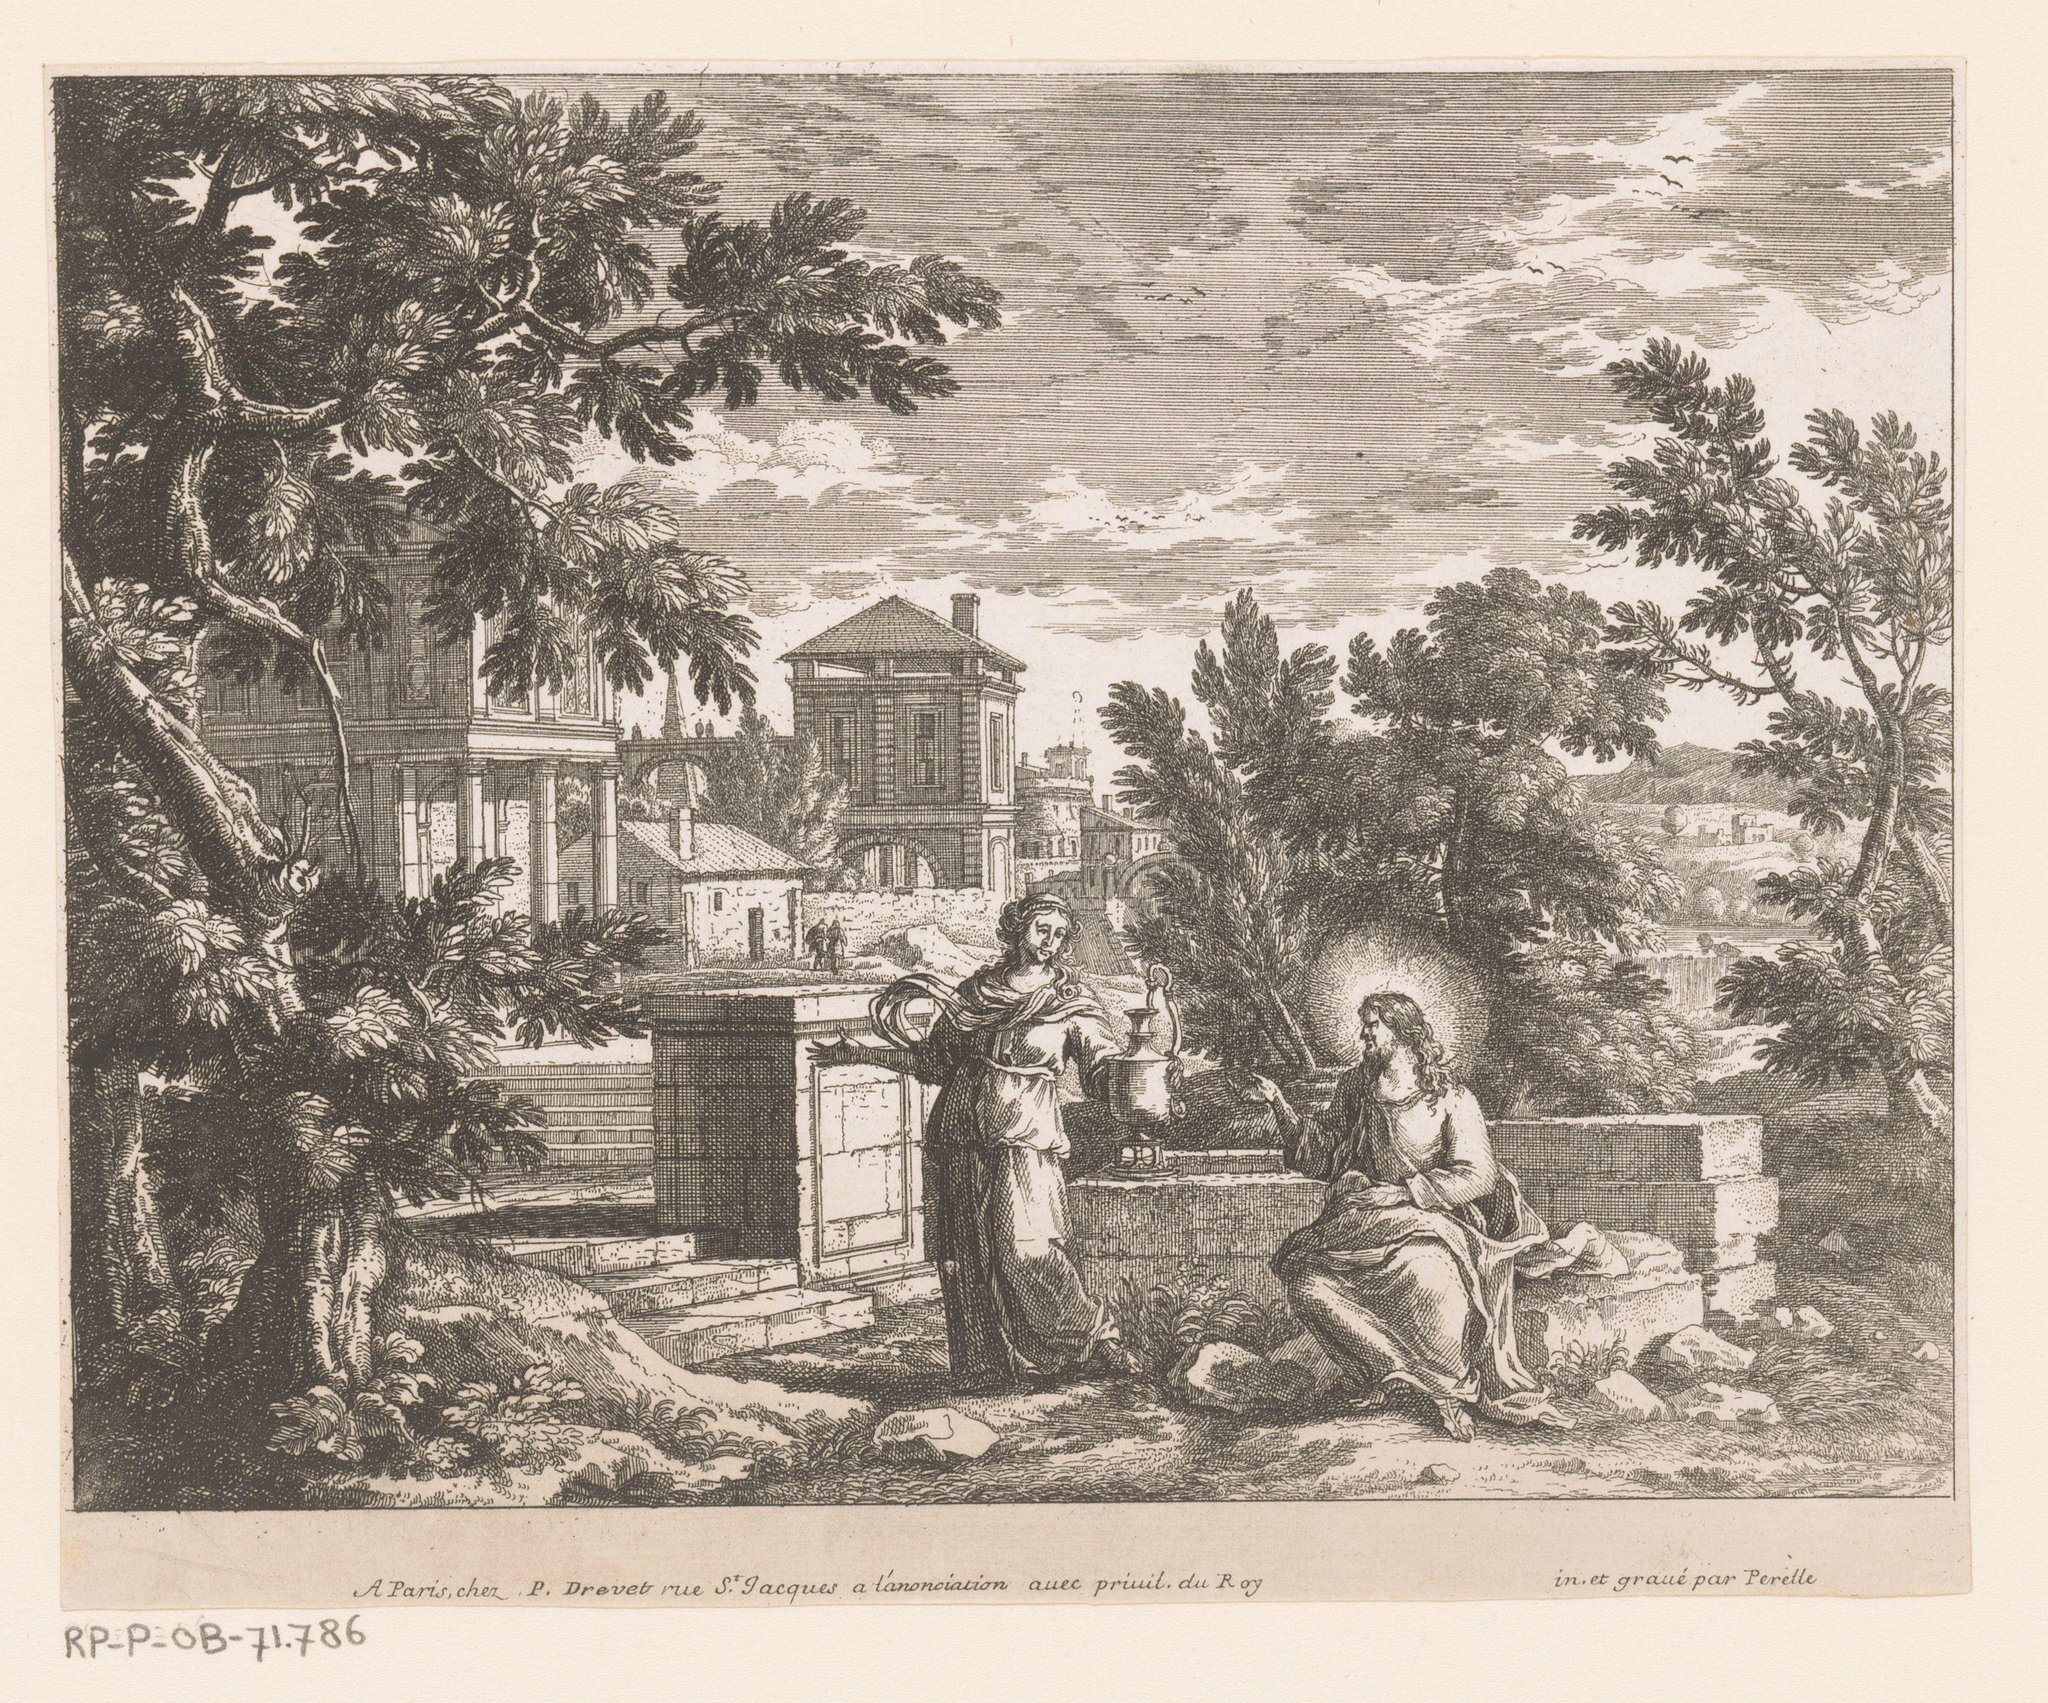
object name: print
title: Christus en de Samaritaanse vrouw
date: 1673-1695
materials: paper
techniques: etching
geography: paris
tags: christ and the woman of samaria: sitting at jacob's well he asks her for a drink from her jug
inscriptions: collector's mark: Lugt 240